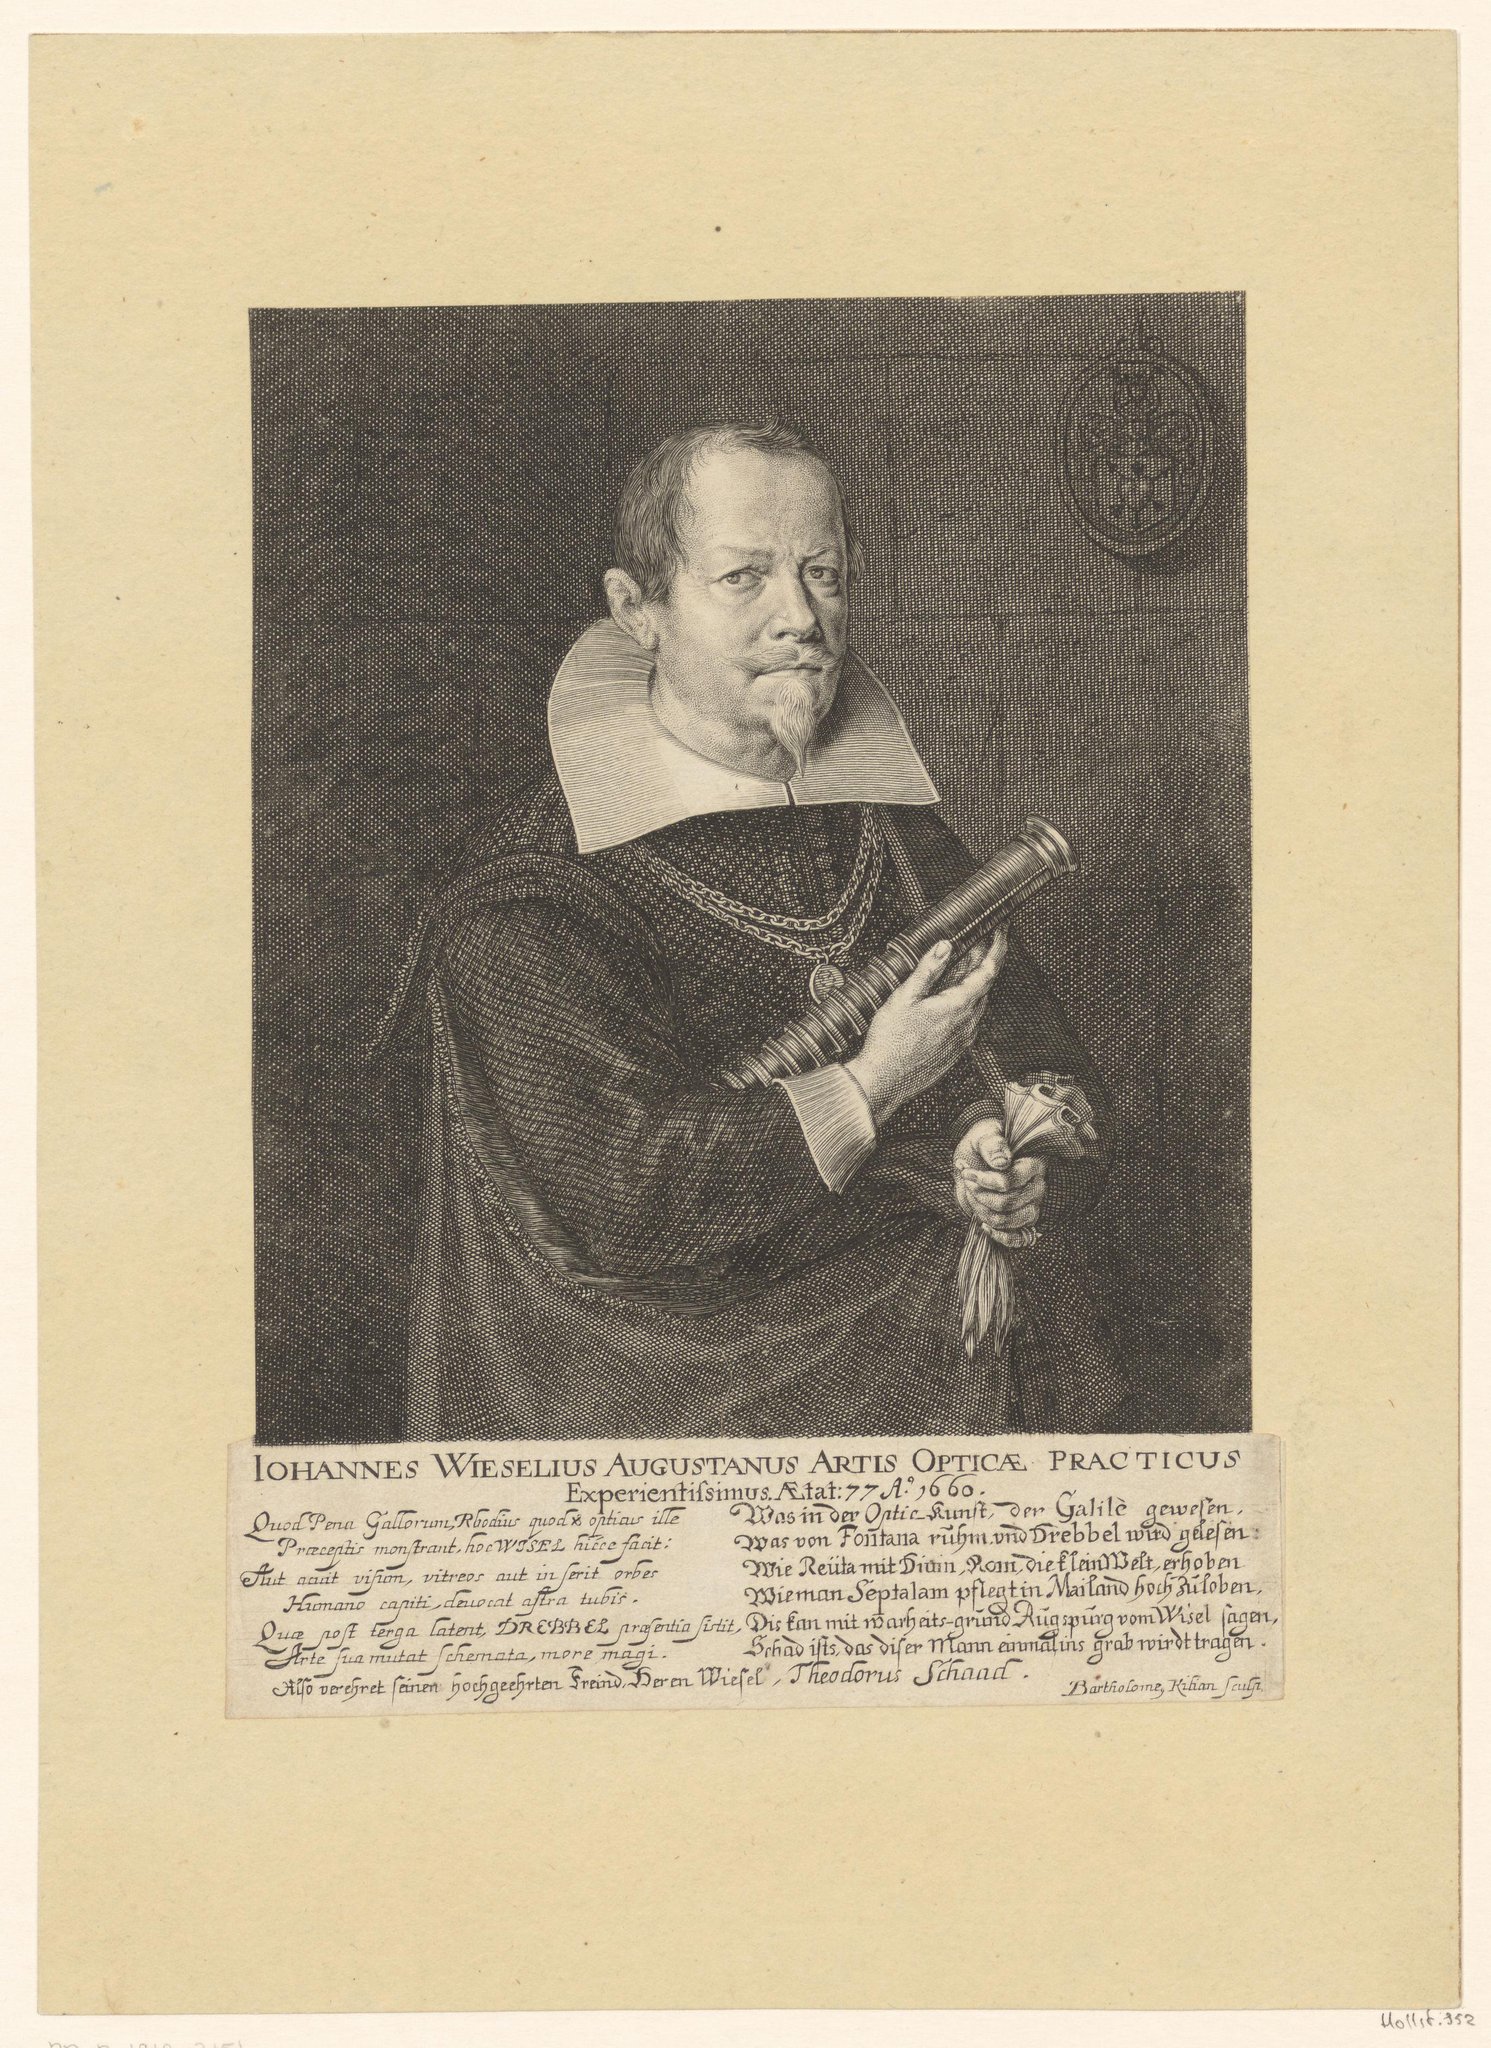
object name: print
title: Portret van Johann Wiesel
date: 1660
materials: paper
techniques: engraving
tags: augsburg, optics (+ portrait of scholar, scientist), historical persons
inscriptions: collector's mark: Lugt 2228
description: Tekst in het Latijn en Duits in de marge.